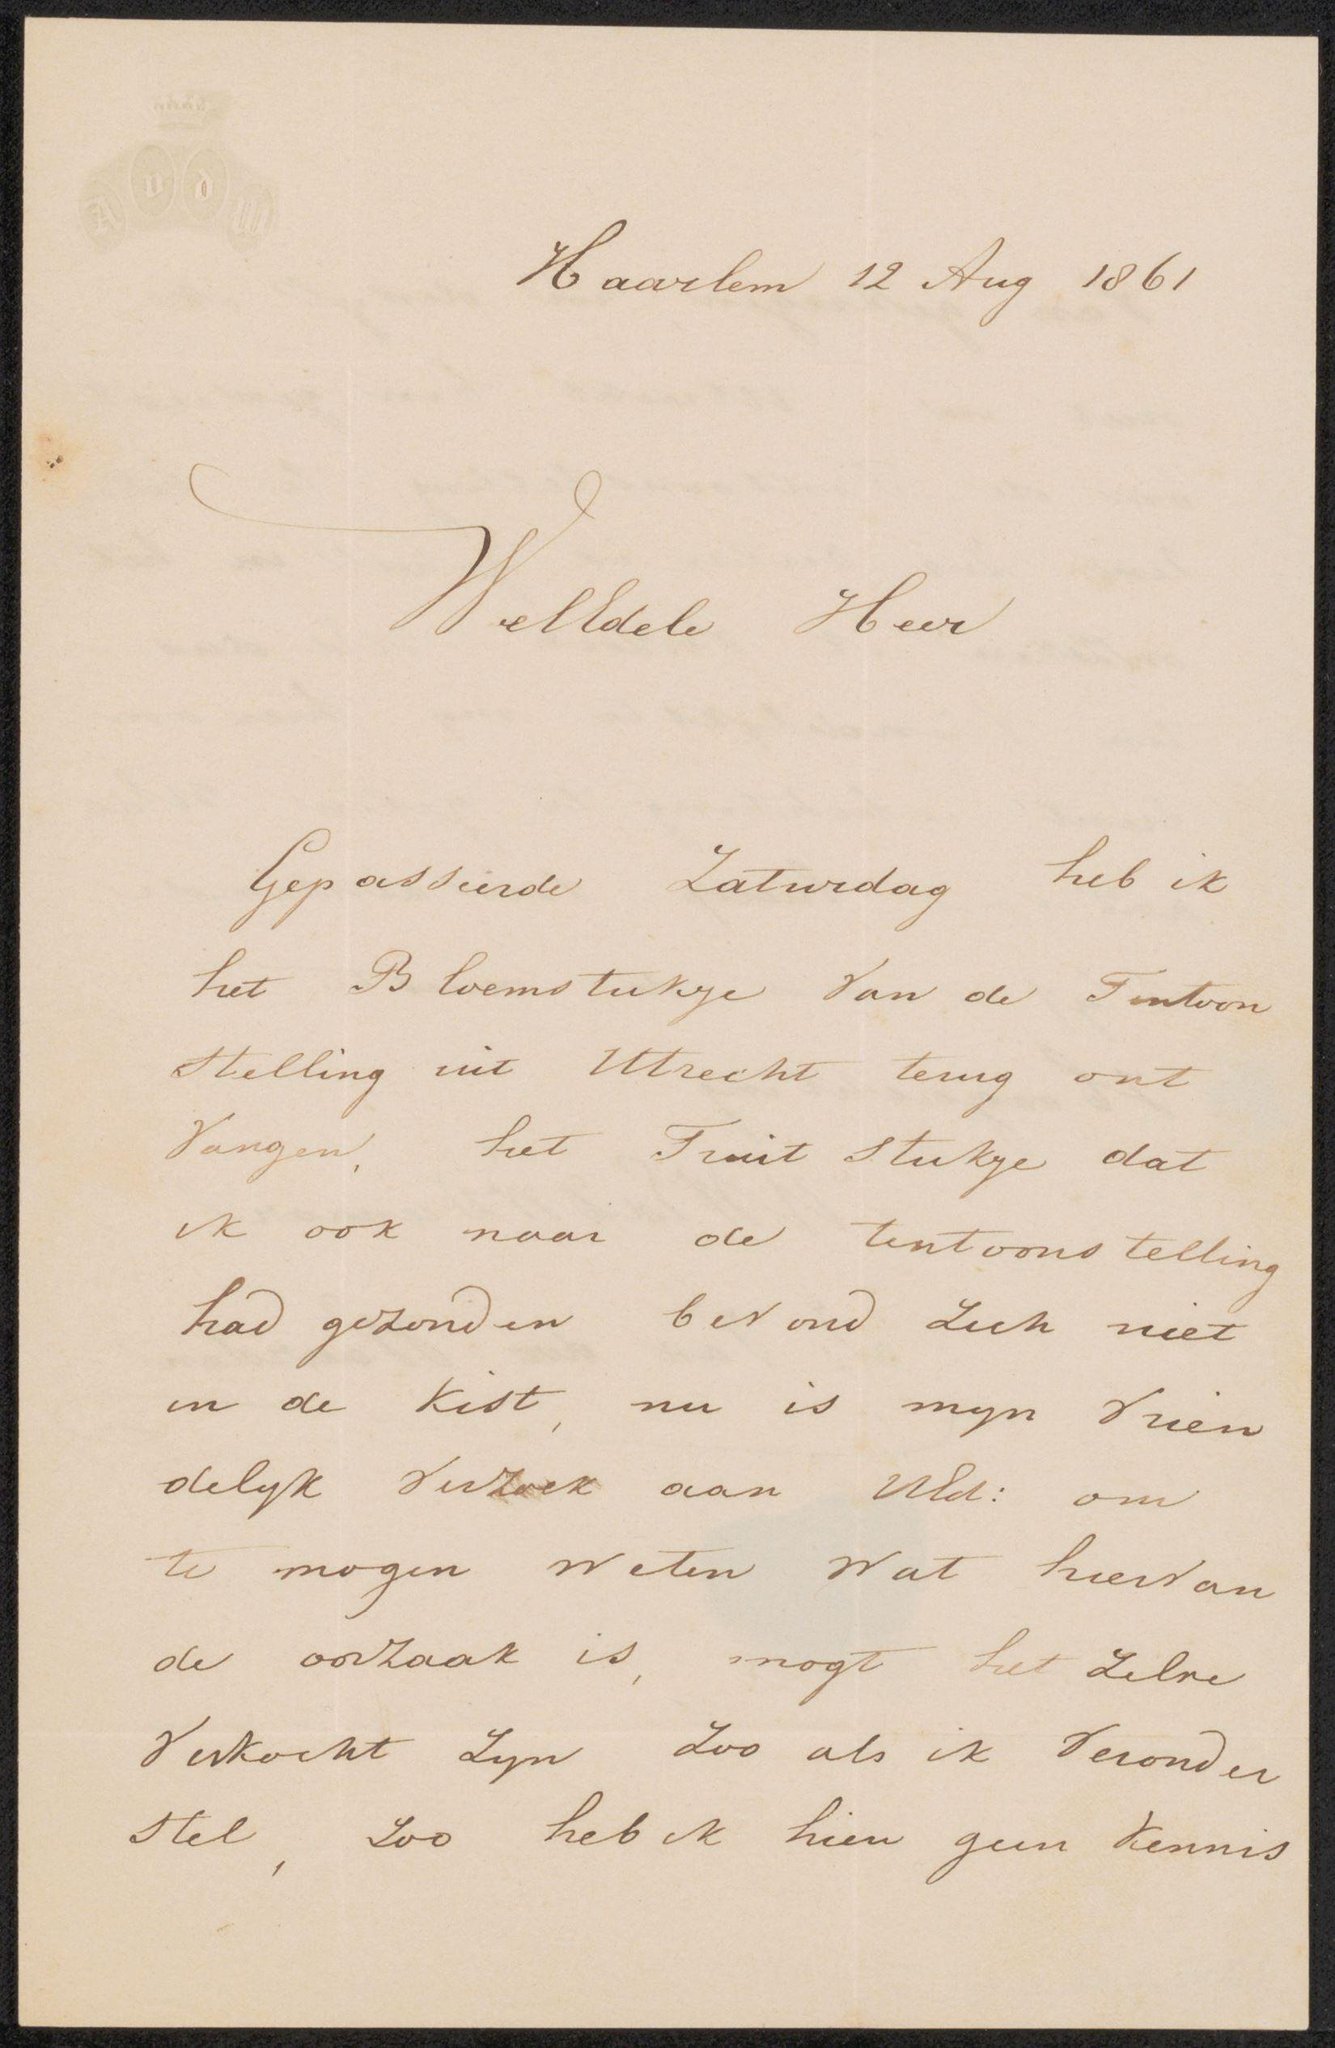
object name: letter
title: Brief aan Pieter Verloren van Themaat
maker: jan van der waarden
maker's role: painter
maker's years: 1811-1872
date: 1861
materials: ink, paper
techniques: pen, writing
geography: haarlem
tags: utrecht, pieter verloren van themaat, painting (including book-illumination, miniature-painting), exhibition ~ art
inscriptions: monogram: ‘Initialen A, v, d en W elk in een apart schild met erboven een kroon.’